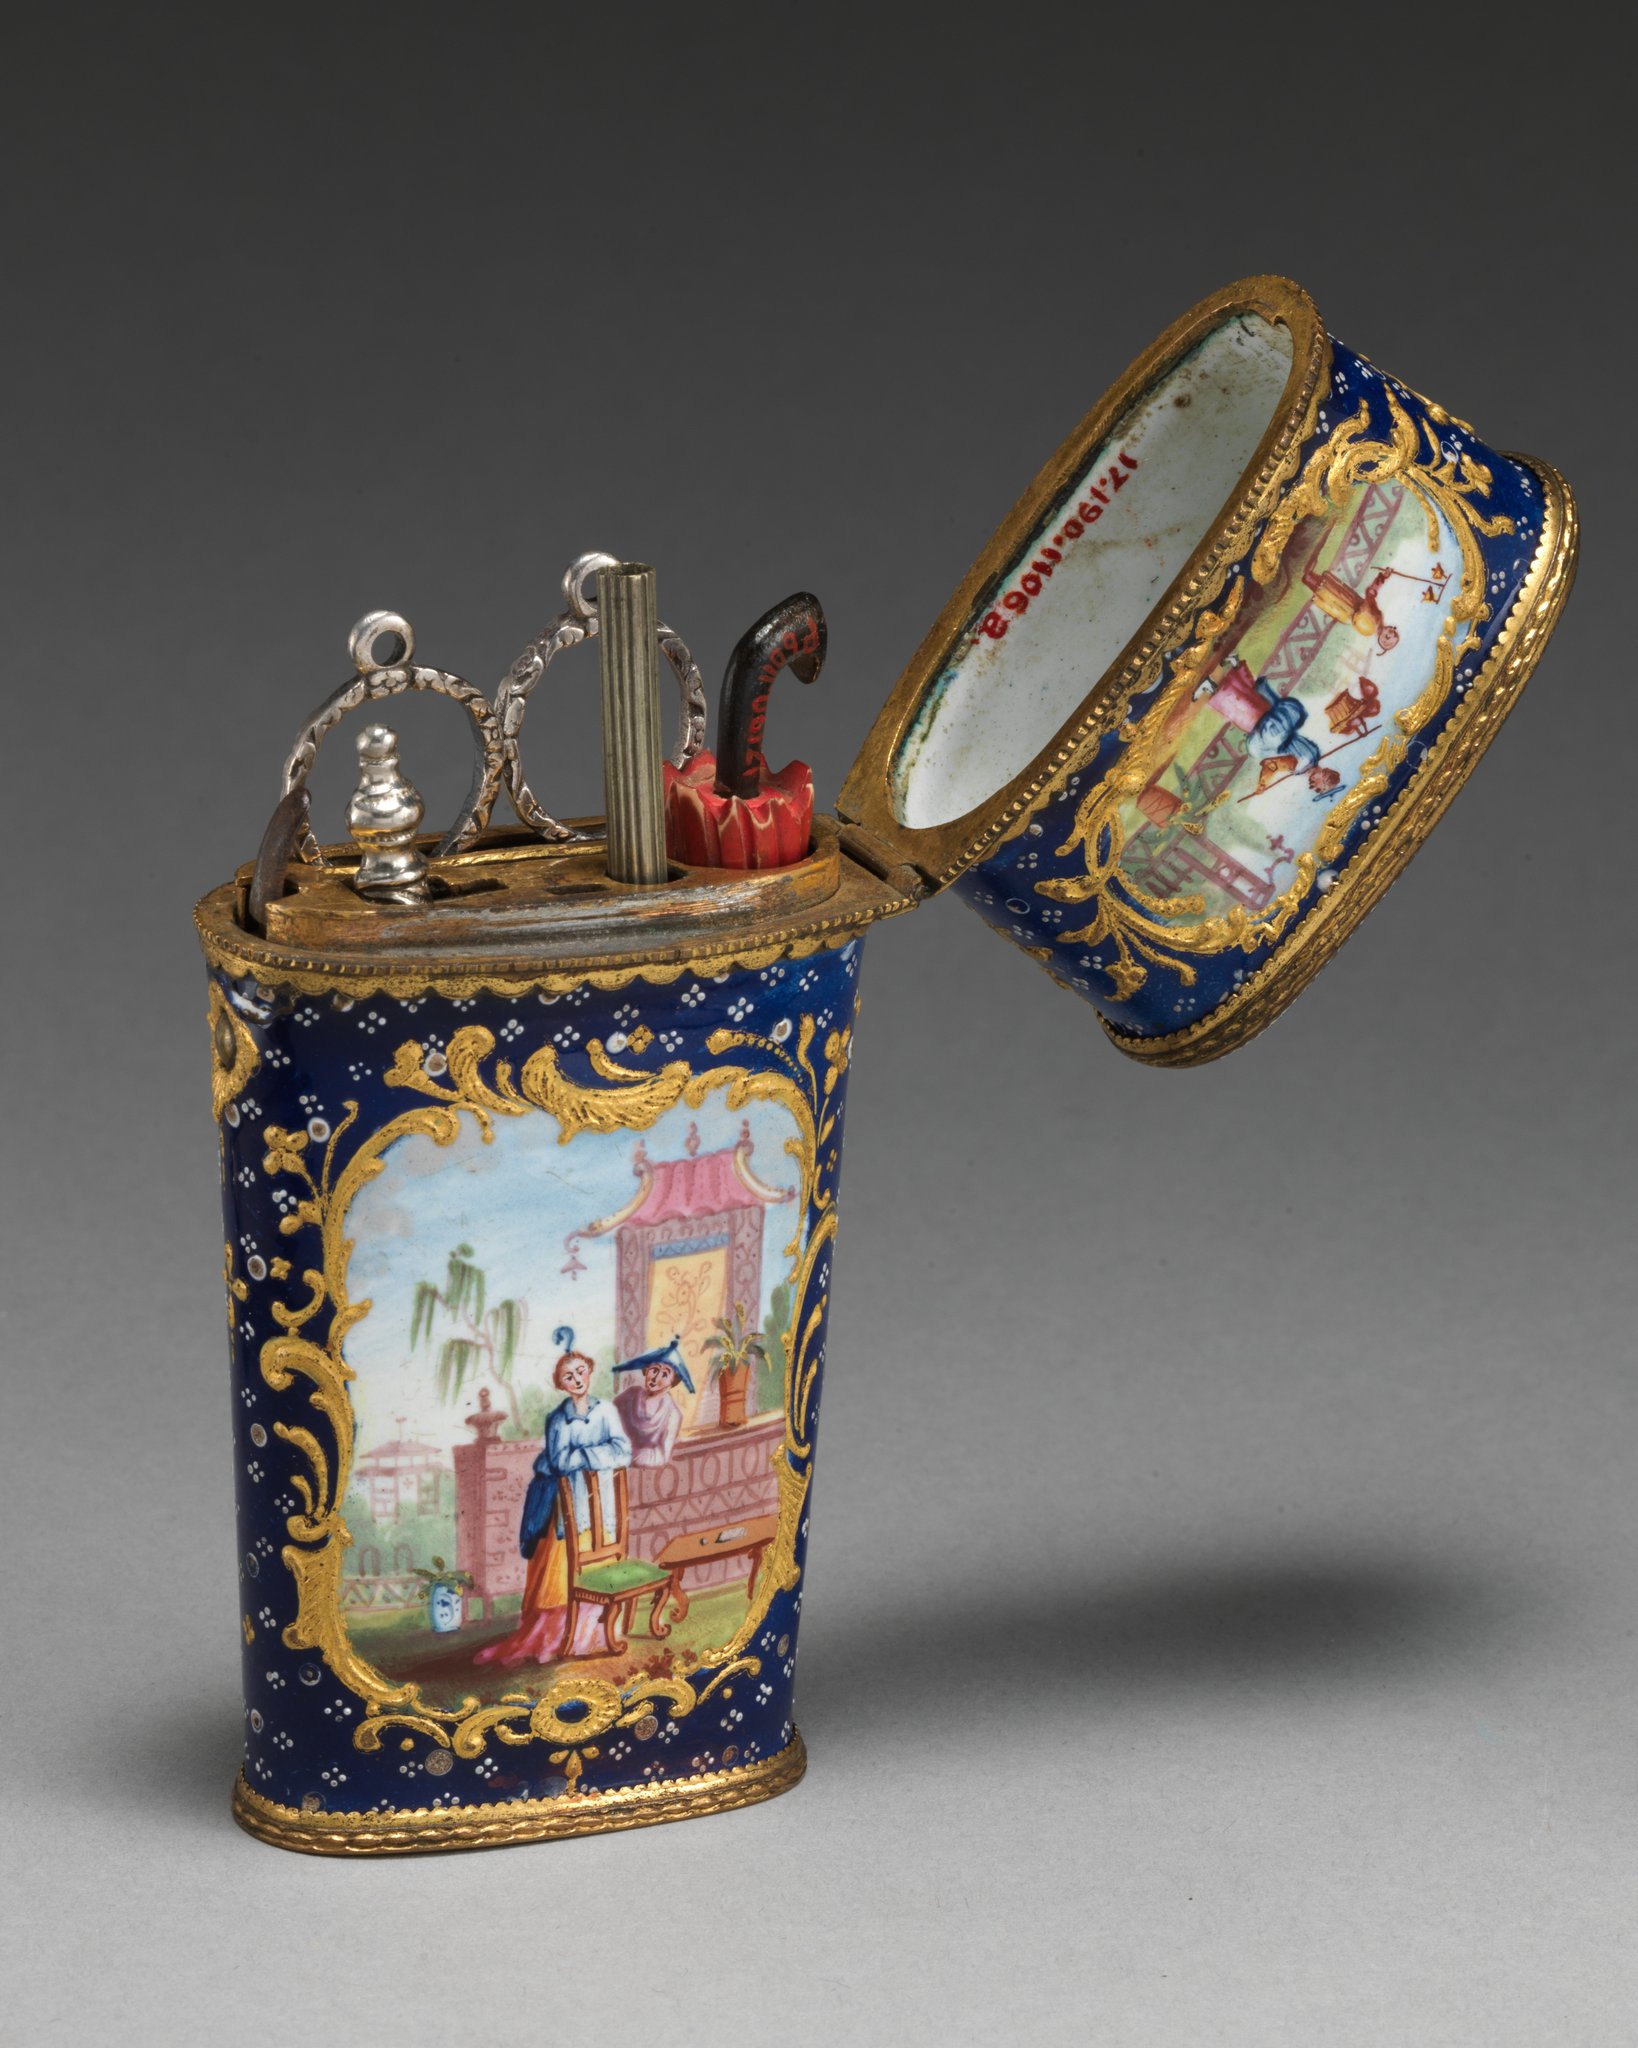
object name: étui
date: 1765-1770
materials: copper, ivory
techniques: enamel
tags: women